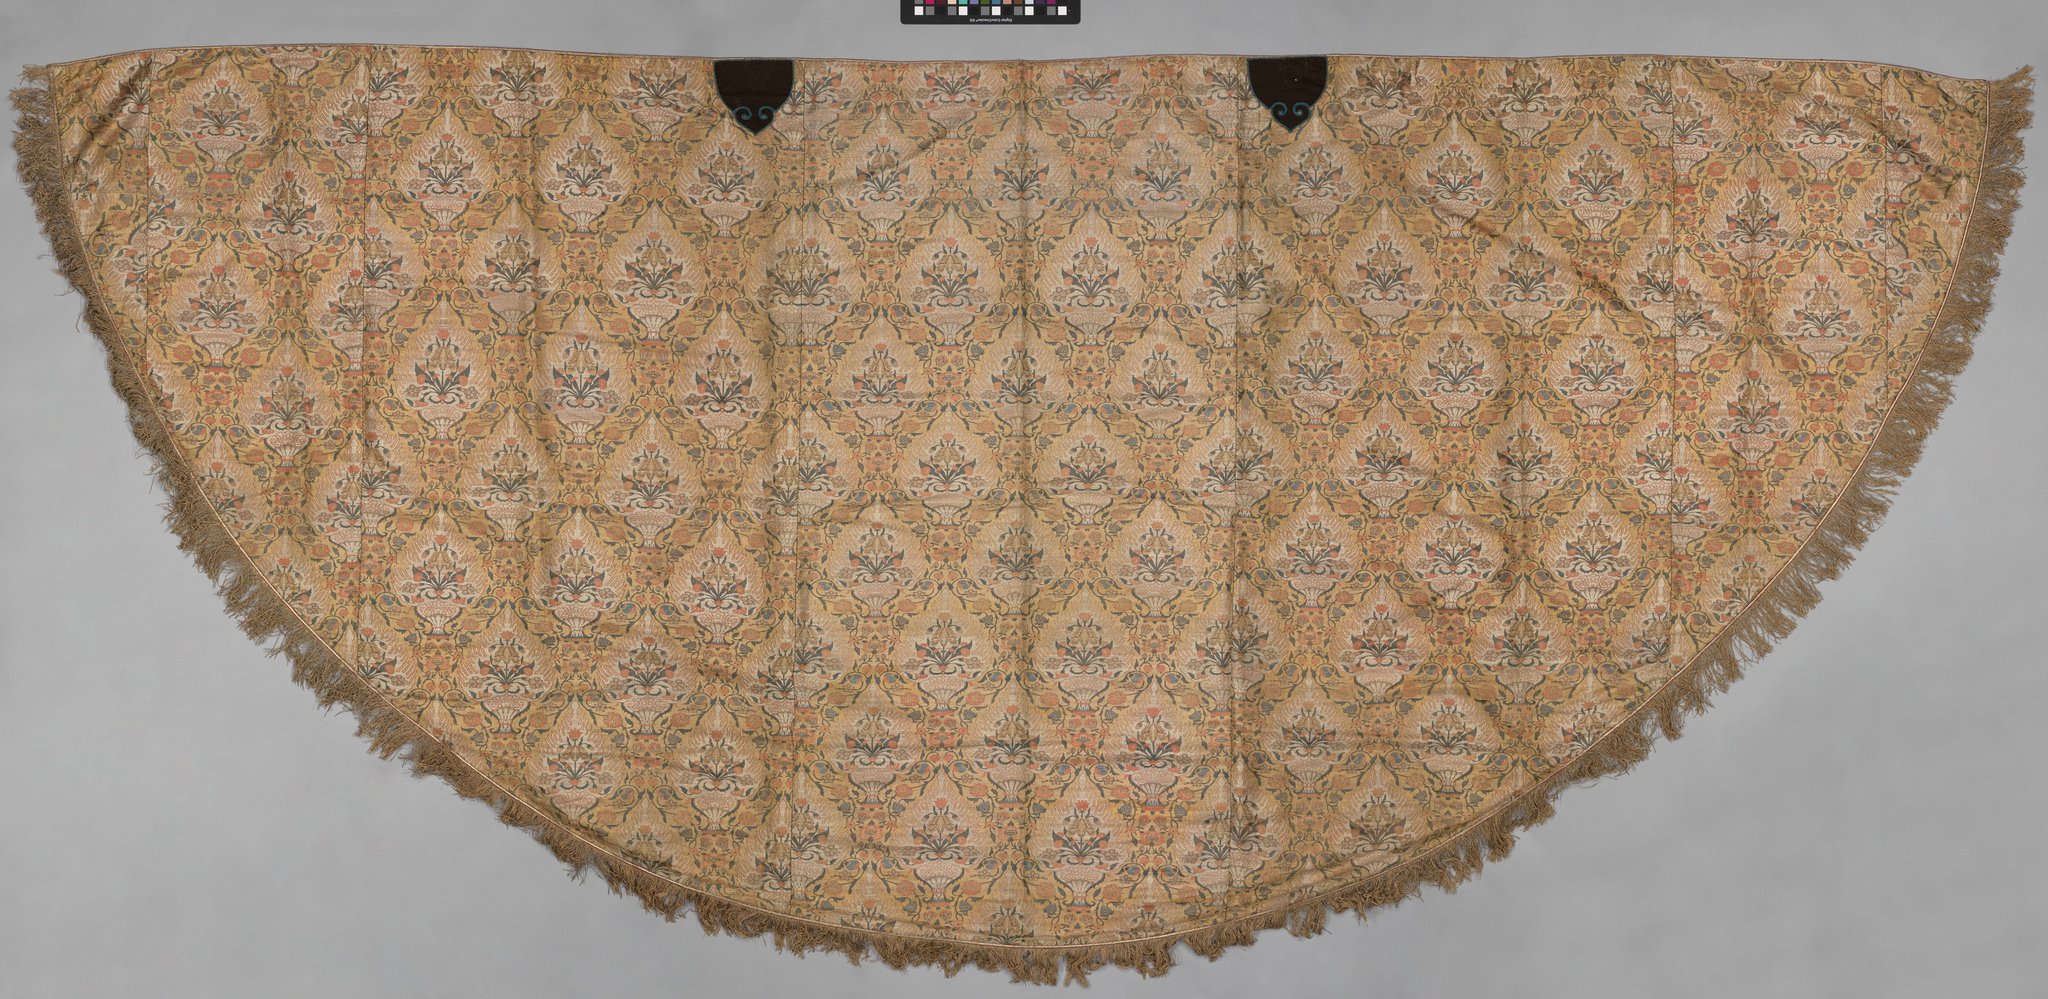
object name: cope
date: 1601-1633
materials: metal thread, silk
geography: iran